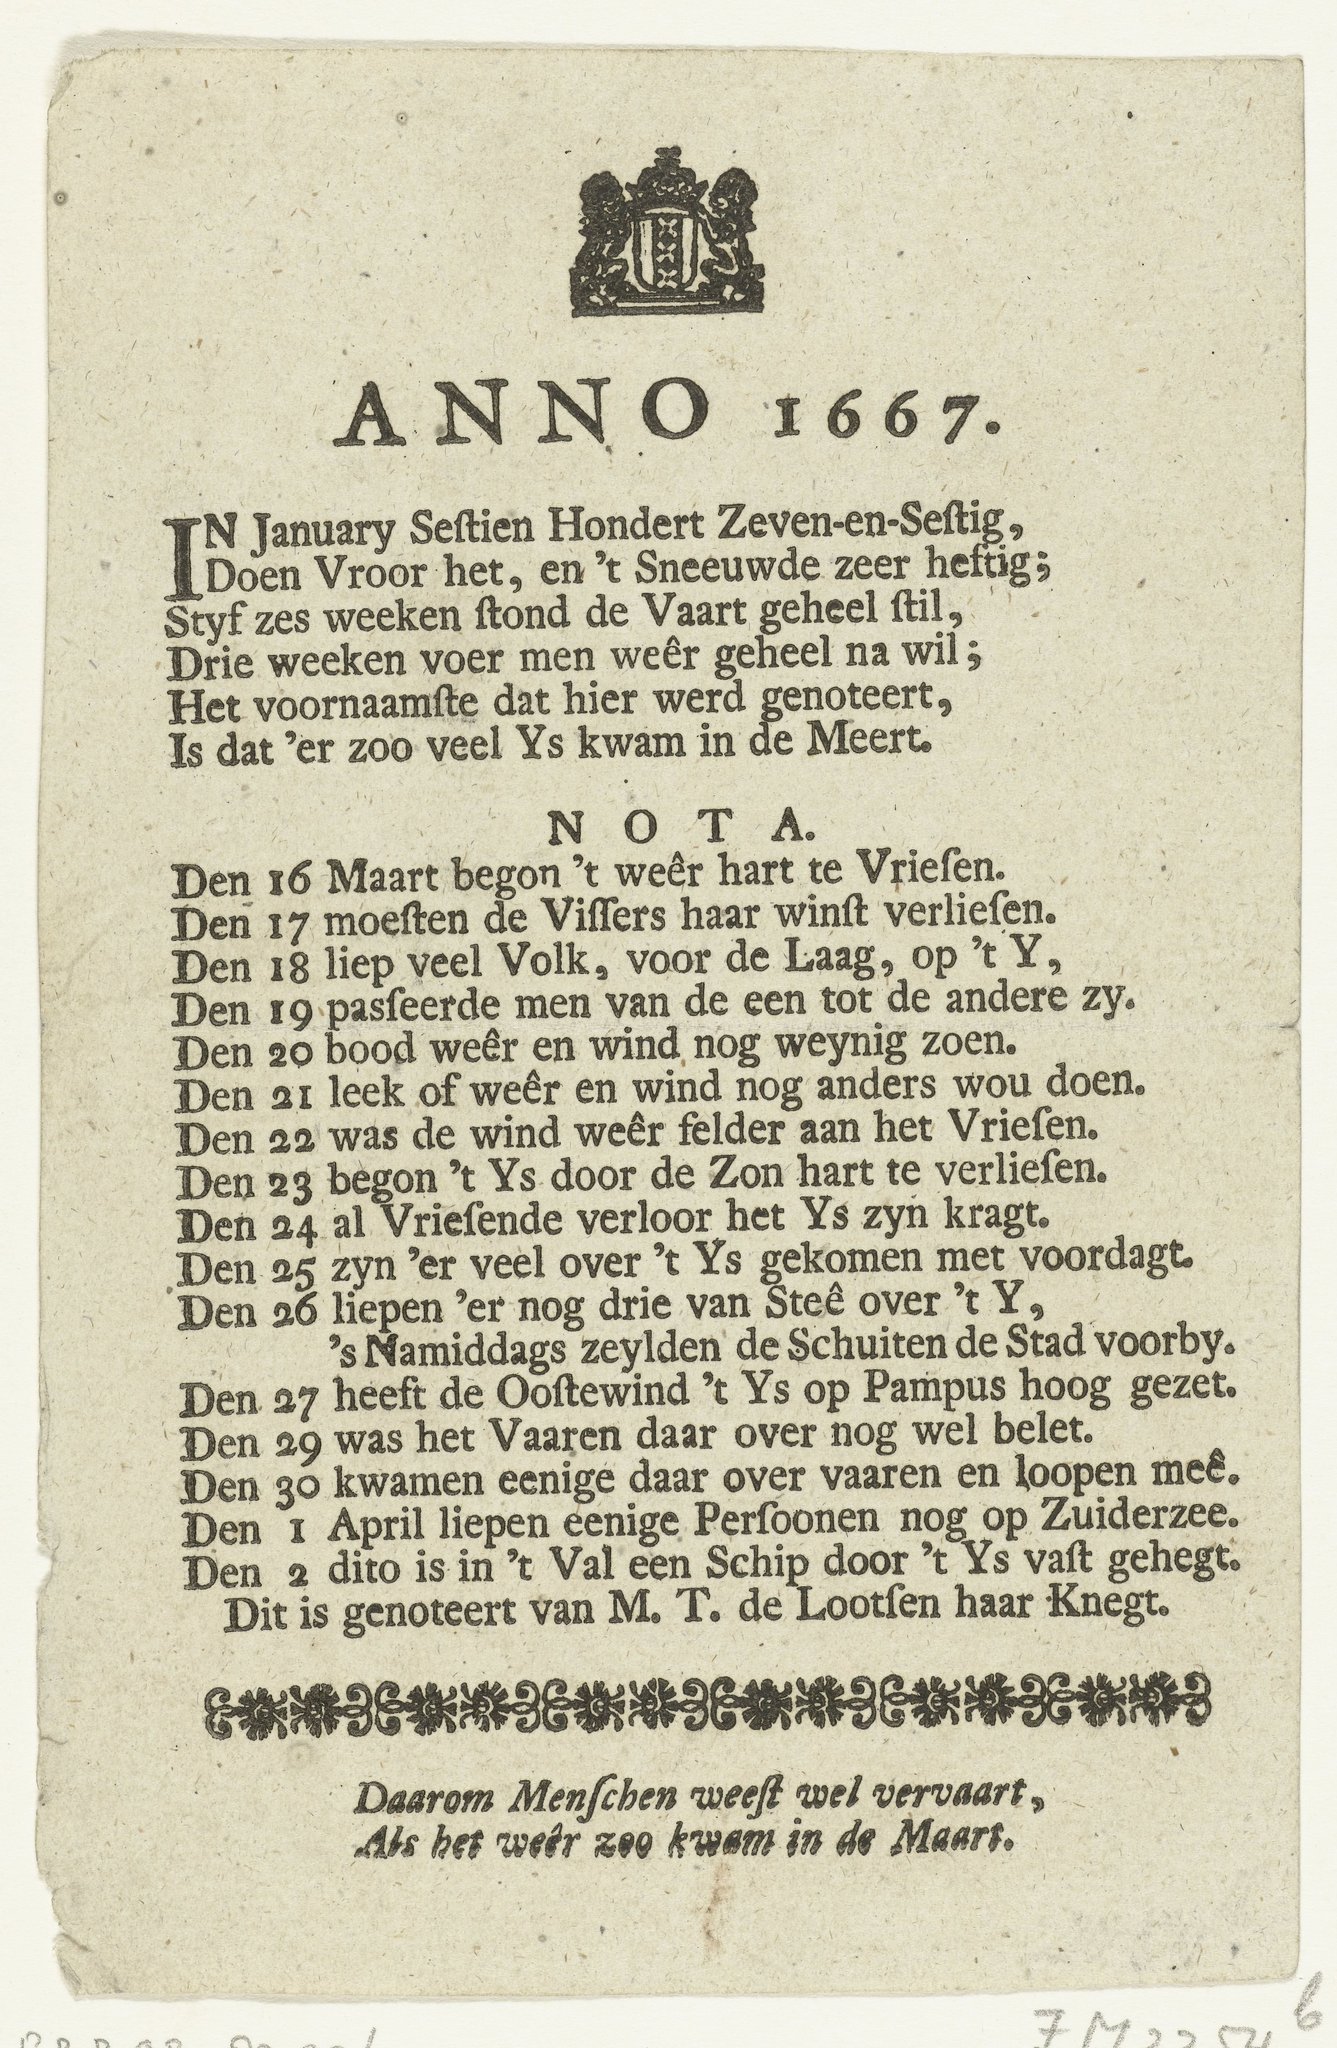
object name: text sheet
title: Vers over de strenge vorst in Amsterdam van maart 1667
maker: Anonymous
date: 1667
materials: paper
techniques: letterpress printing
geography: amsterdam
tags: amsterdam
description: Tekstblad met twee verzen en een aantekening over de strenge vorst van maart 1667 te Amsterdam. Bovenaan een vignet met het wapen van Amsterdam.